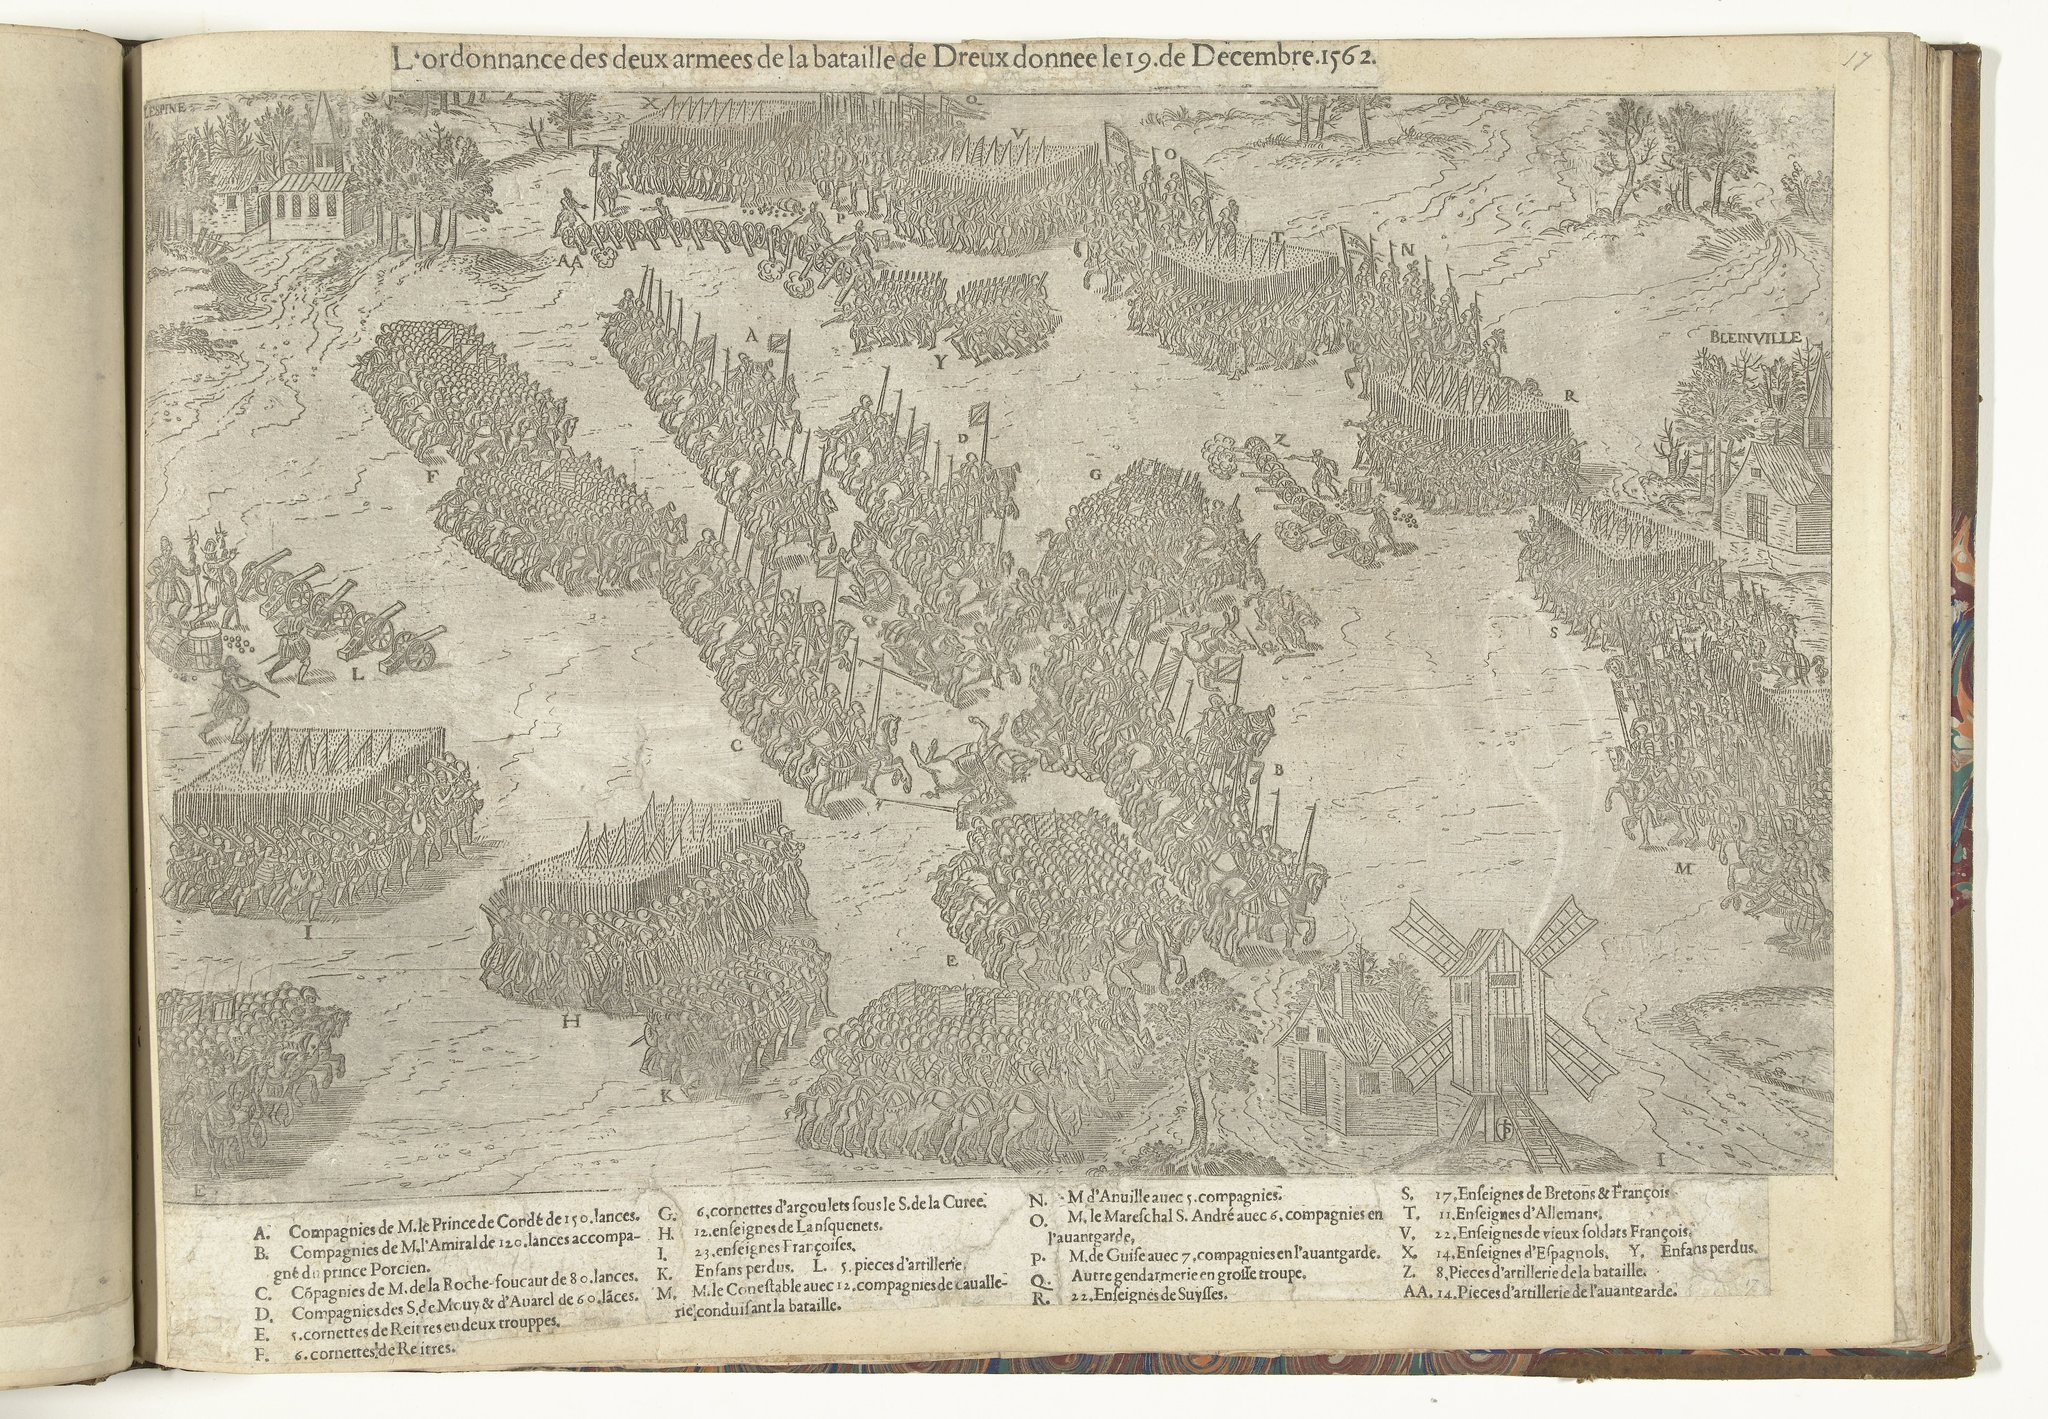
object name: print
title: L'ordonnance des deux armees de la bataille de Dreux donnee le 19. de Decembre 1562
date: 1570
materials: paper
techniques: etching, letterpress printing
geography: france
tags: battle, fighting in general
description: Slagorde van de legers in de slag bij Dreux tussen de hugenoten en de katholieken bij het eerste treffen op 19 december 1562. Gezicht op het slagveld. In het onderschrift de legenda A-AA in het Frans. Ongenummerd.